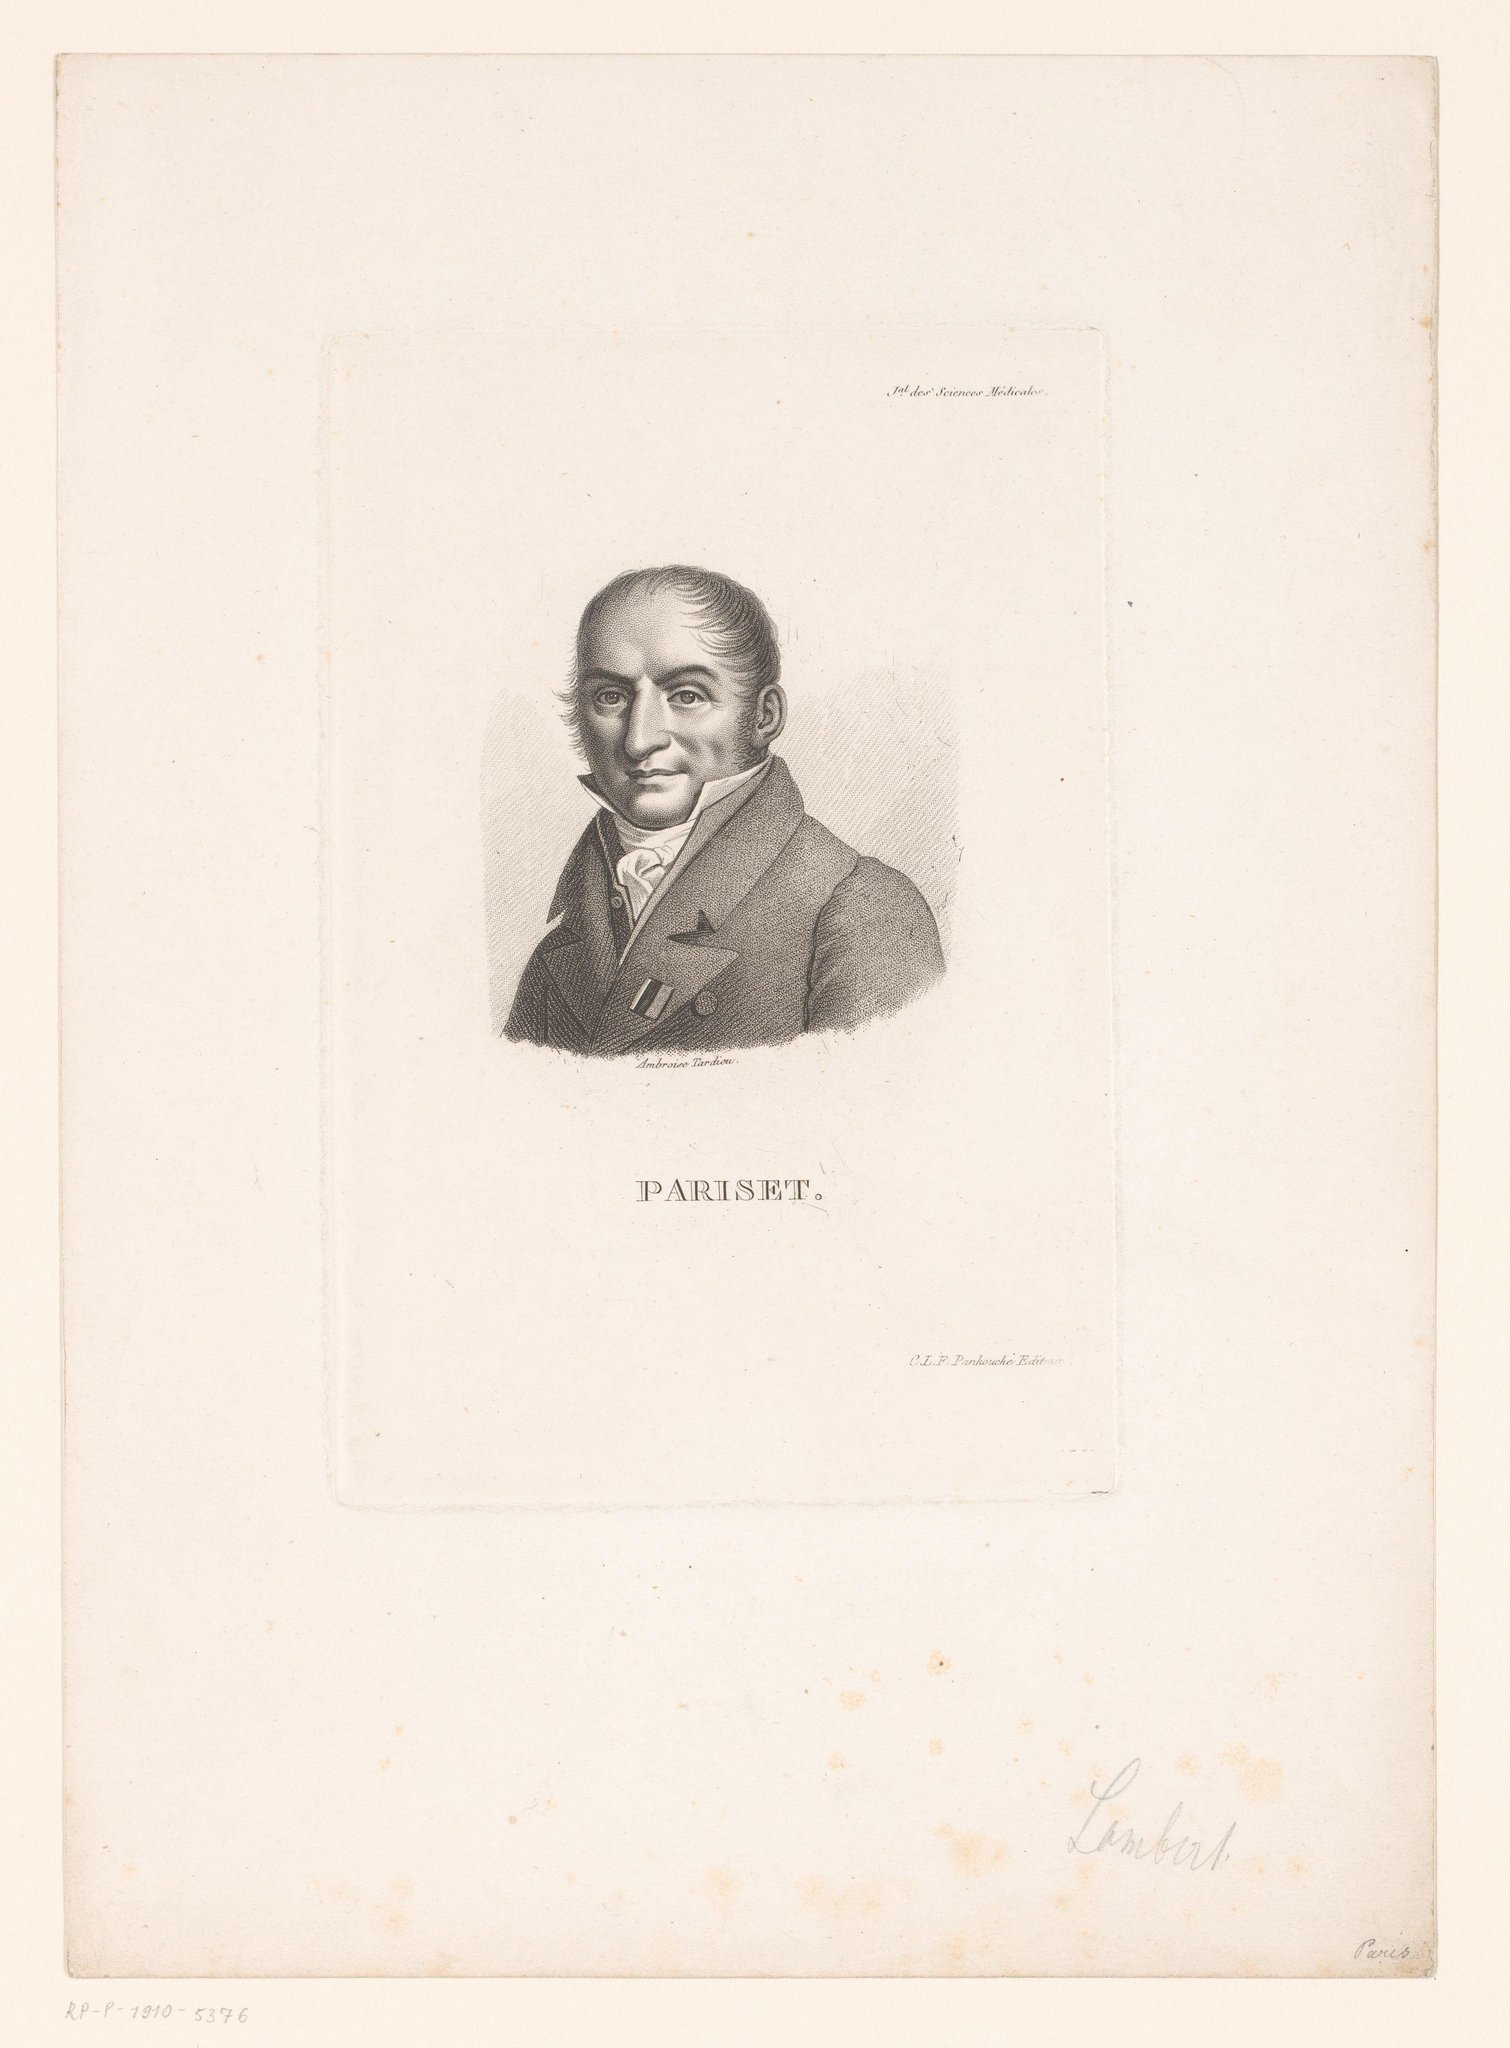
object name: print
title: Pariset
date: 1797-1841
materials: paper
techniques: roulette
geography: paris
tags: paris, historical persons, physician, doctor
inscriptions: collector's mark: Lugt 2228